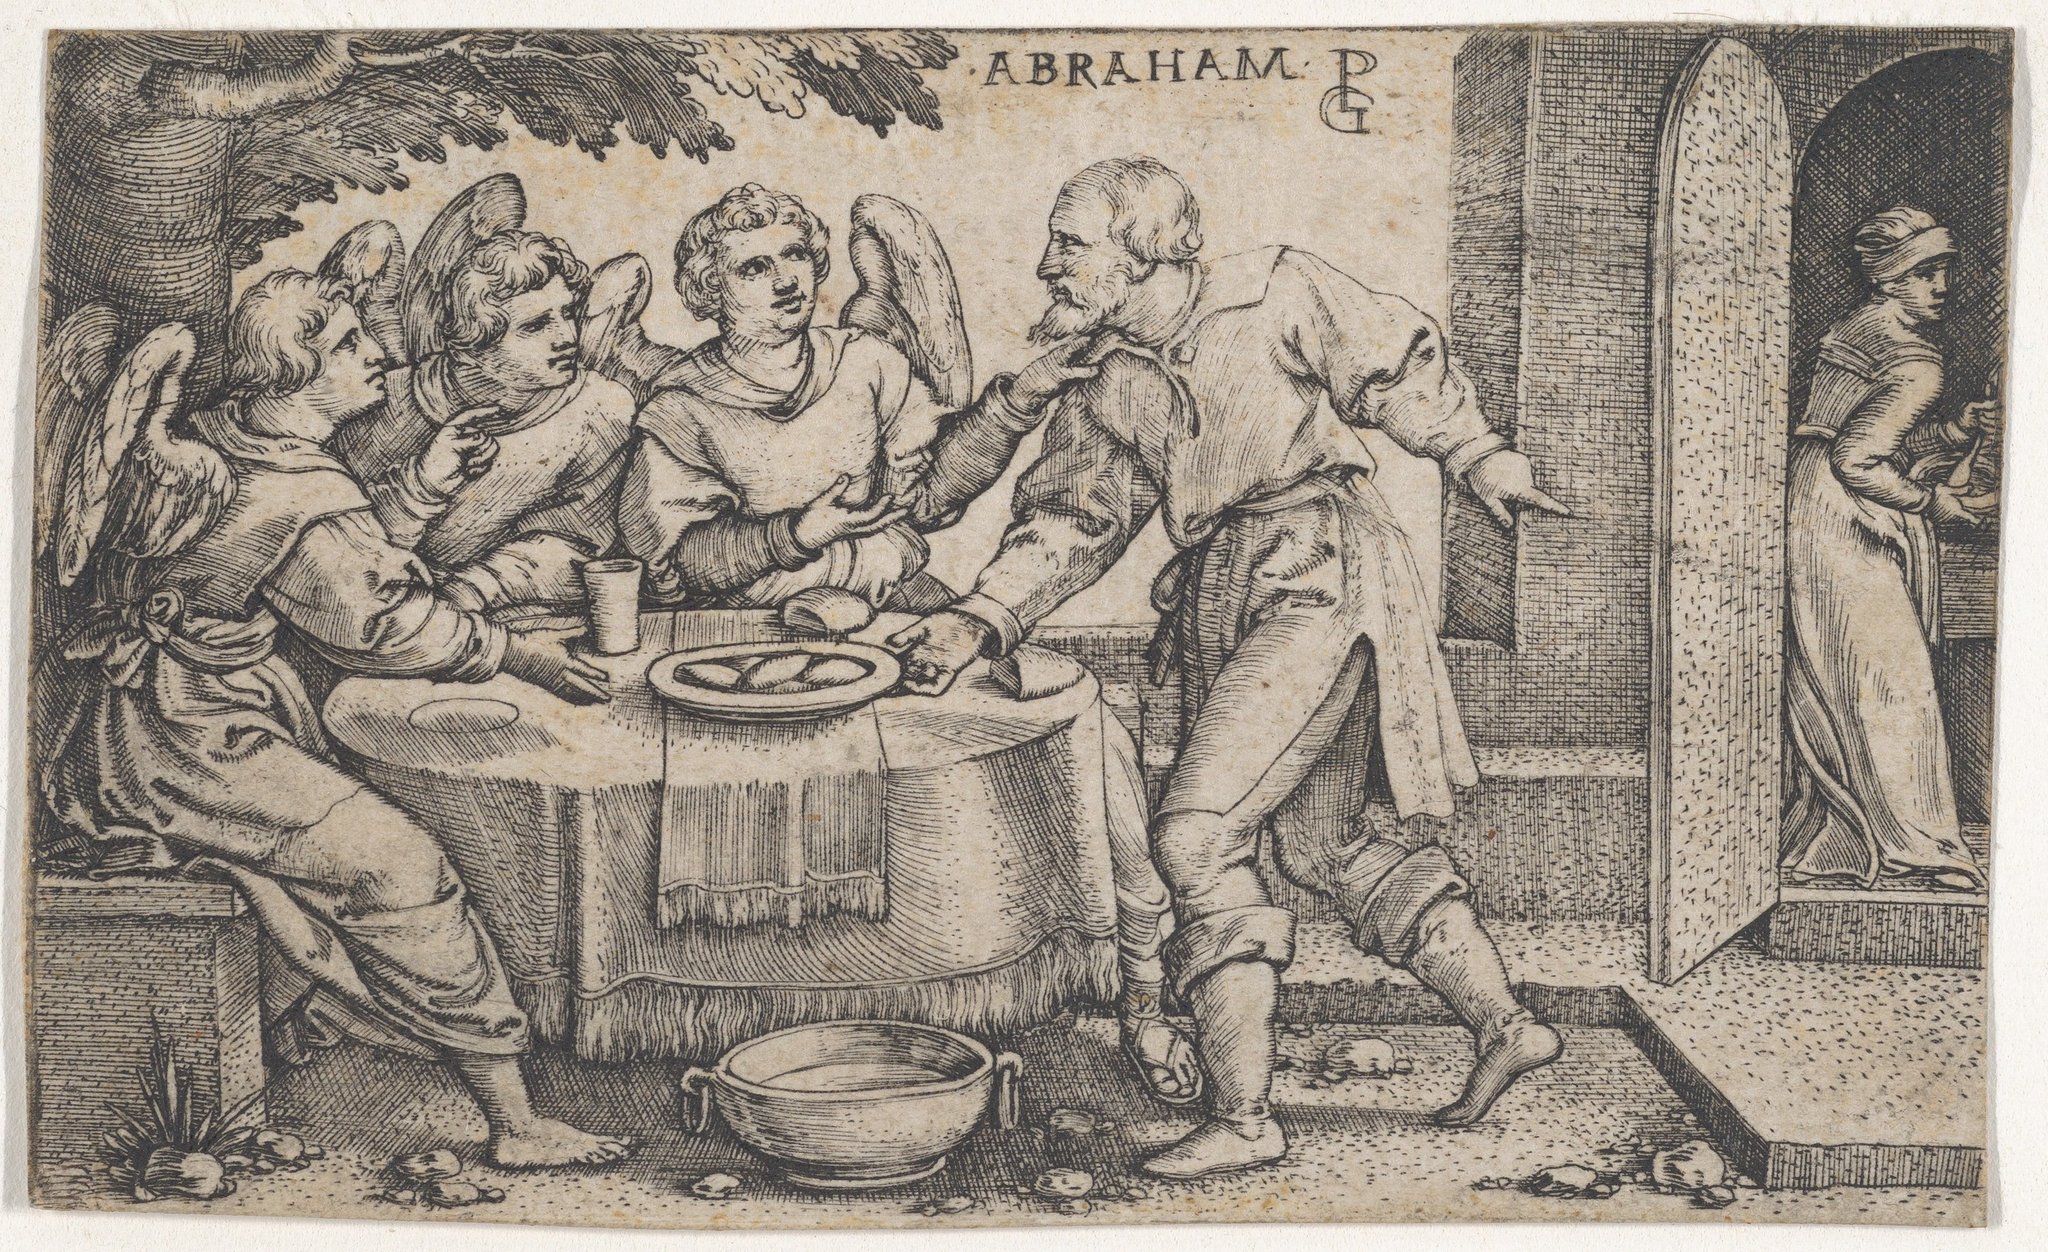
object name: print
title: The Three Angels Visiting Abraham, from "The Story of Abraham"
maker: georg pencz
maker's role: artist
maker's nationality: german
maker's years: 1500-1550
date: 1500-1550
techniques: engraving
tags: women,angels,abraham,tables